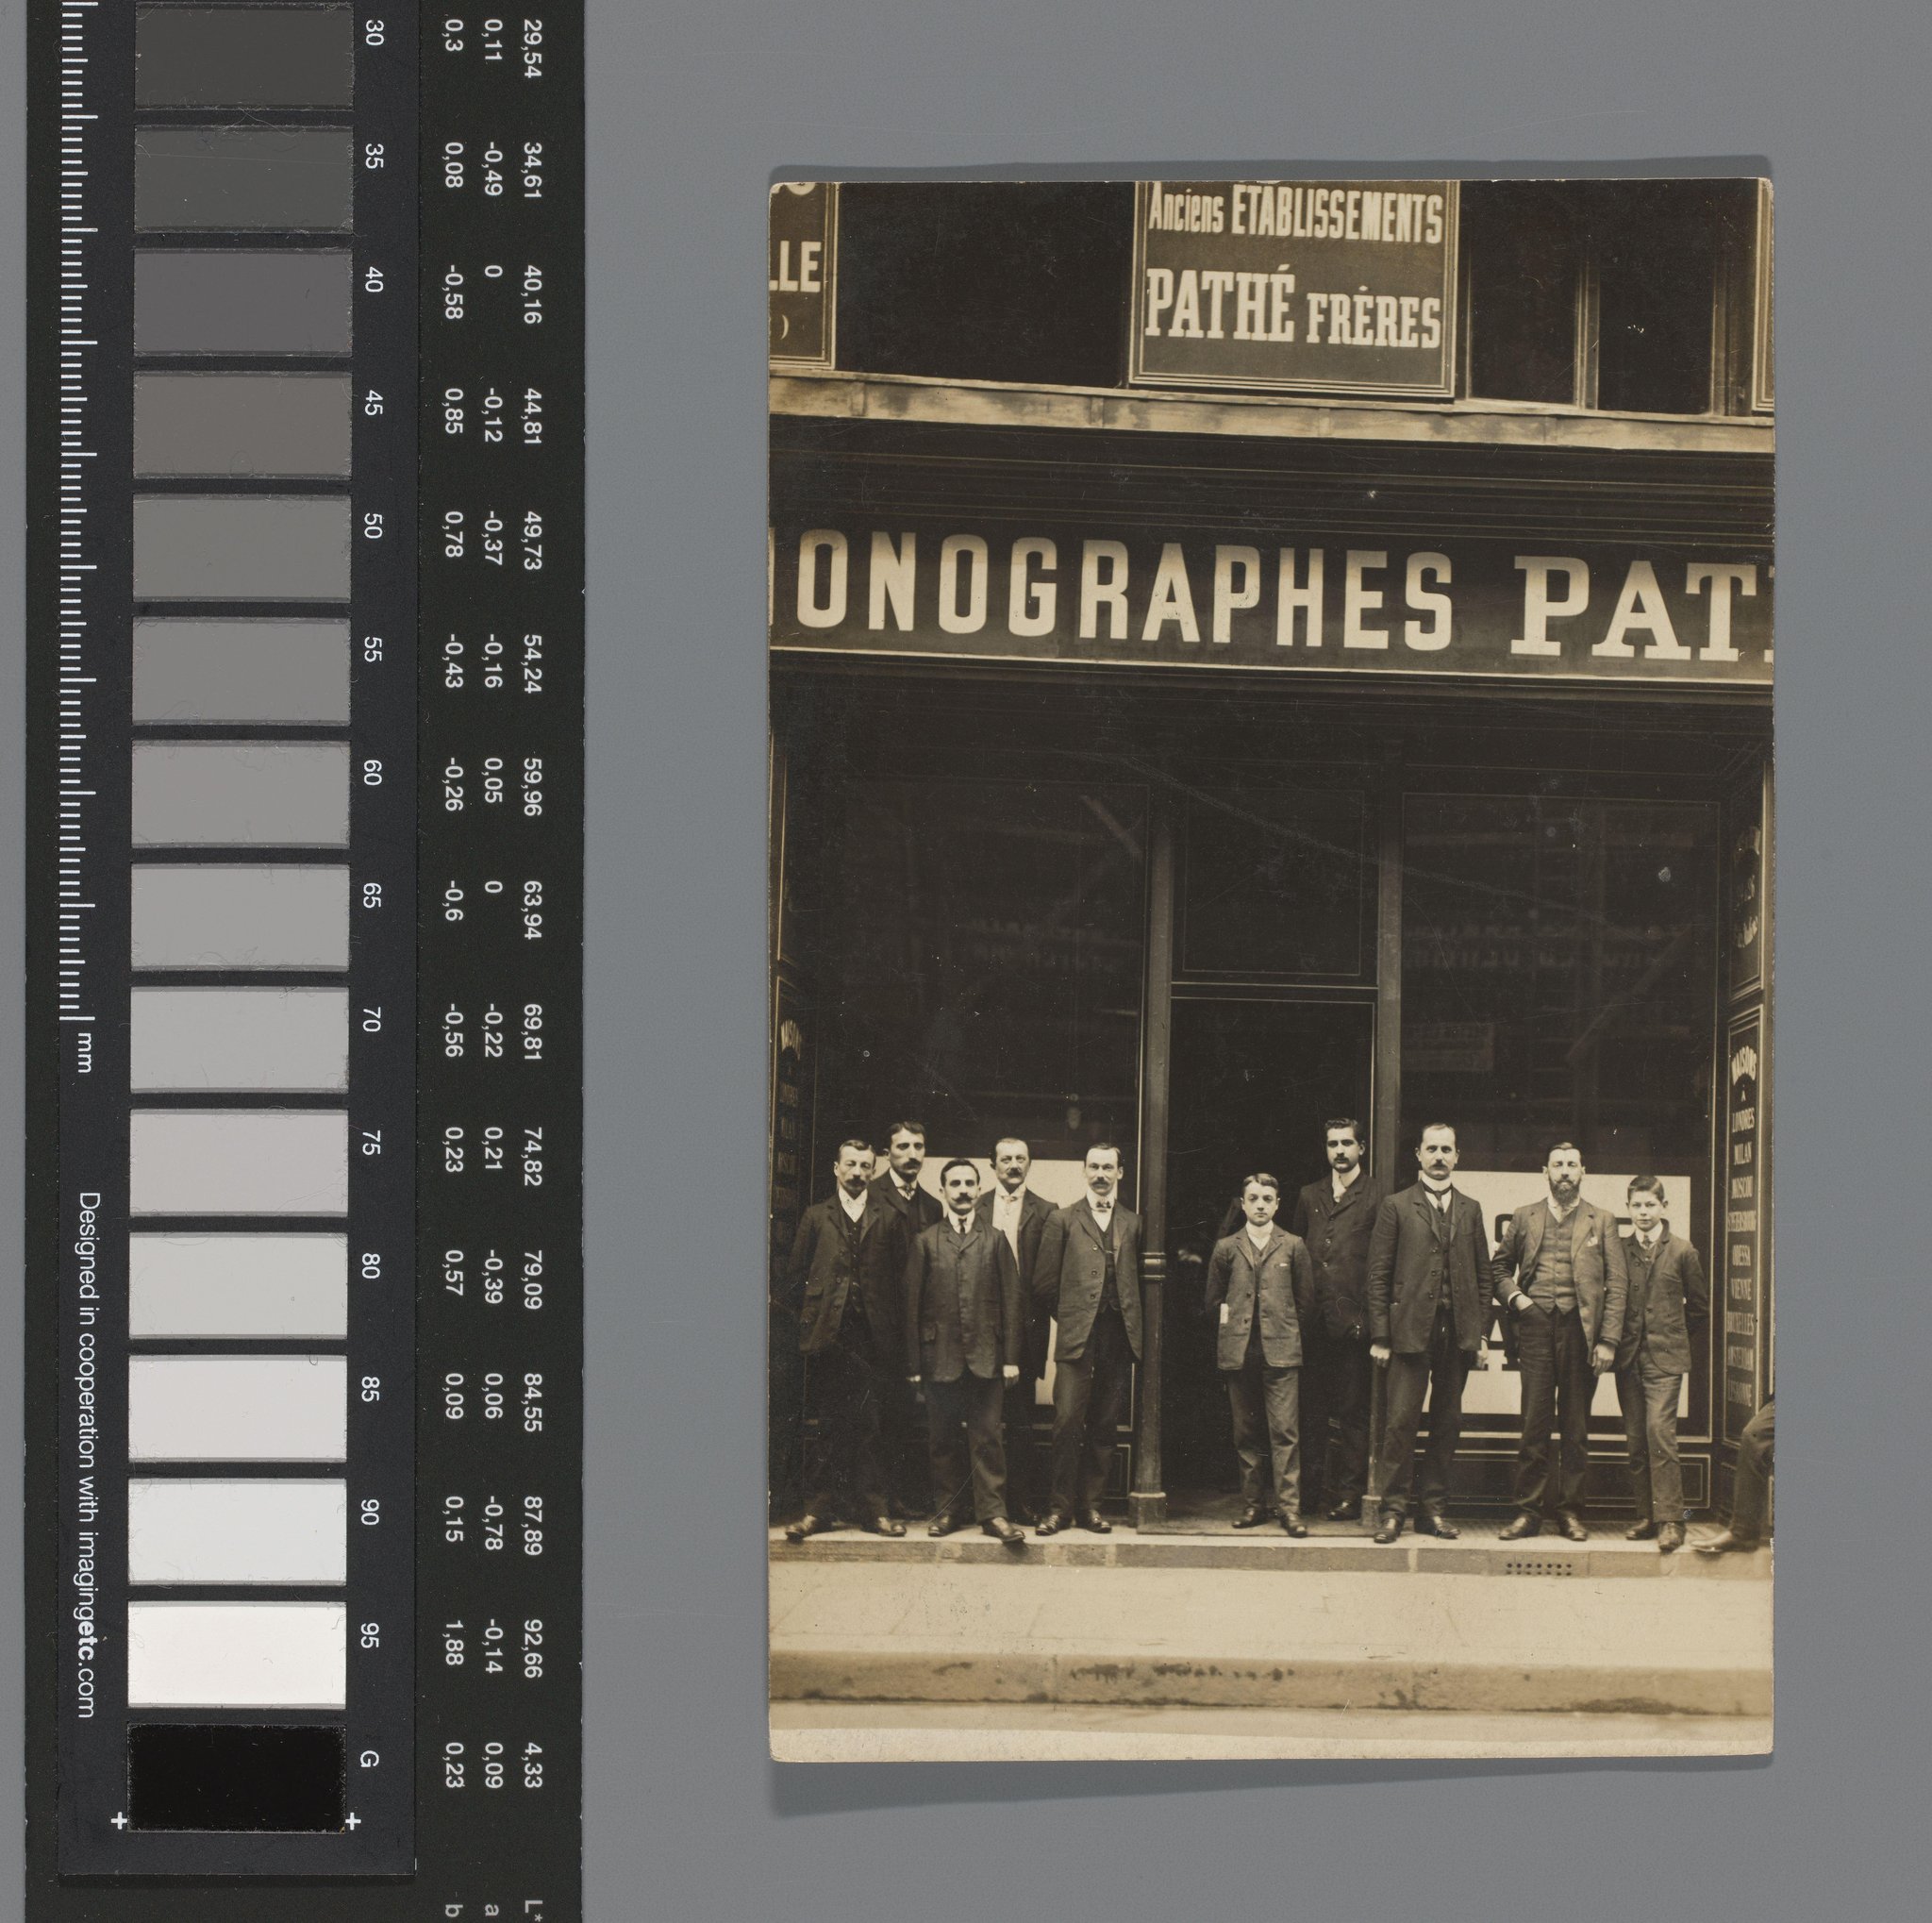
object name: photograph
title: Winkel van Pathé Phonographes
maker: Anonymous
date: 1920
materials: photographic support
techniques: gelatin silver print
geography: paris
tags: paris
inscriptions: inscription: ‘CARTE POSTALE’, inscription: ‘PATHÉ frères PHONOGRAPHES / 98, RUE DE RICHELIEU, PARIS (2e) / tel. 247-44 et 247-65’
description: Winkel van Pathé Phonographes, 98 rue de Richelieu, Parijs.